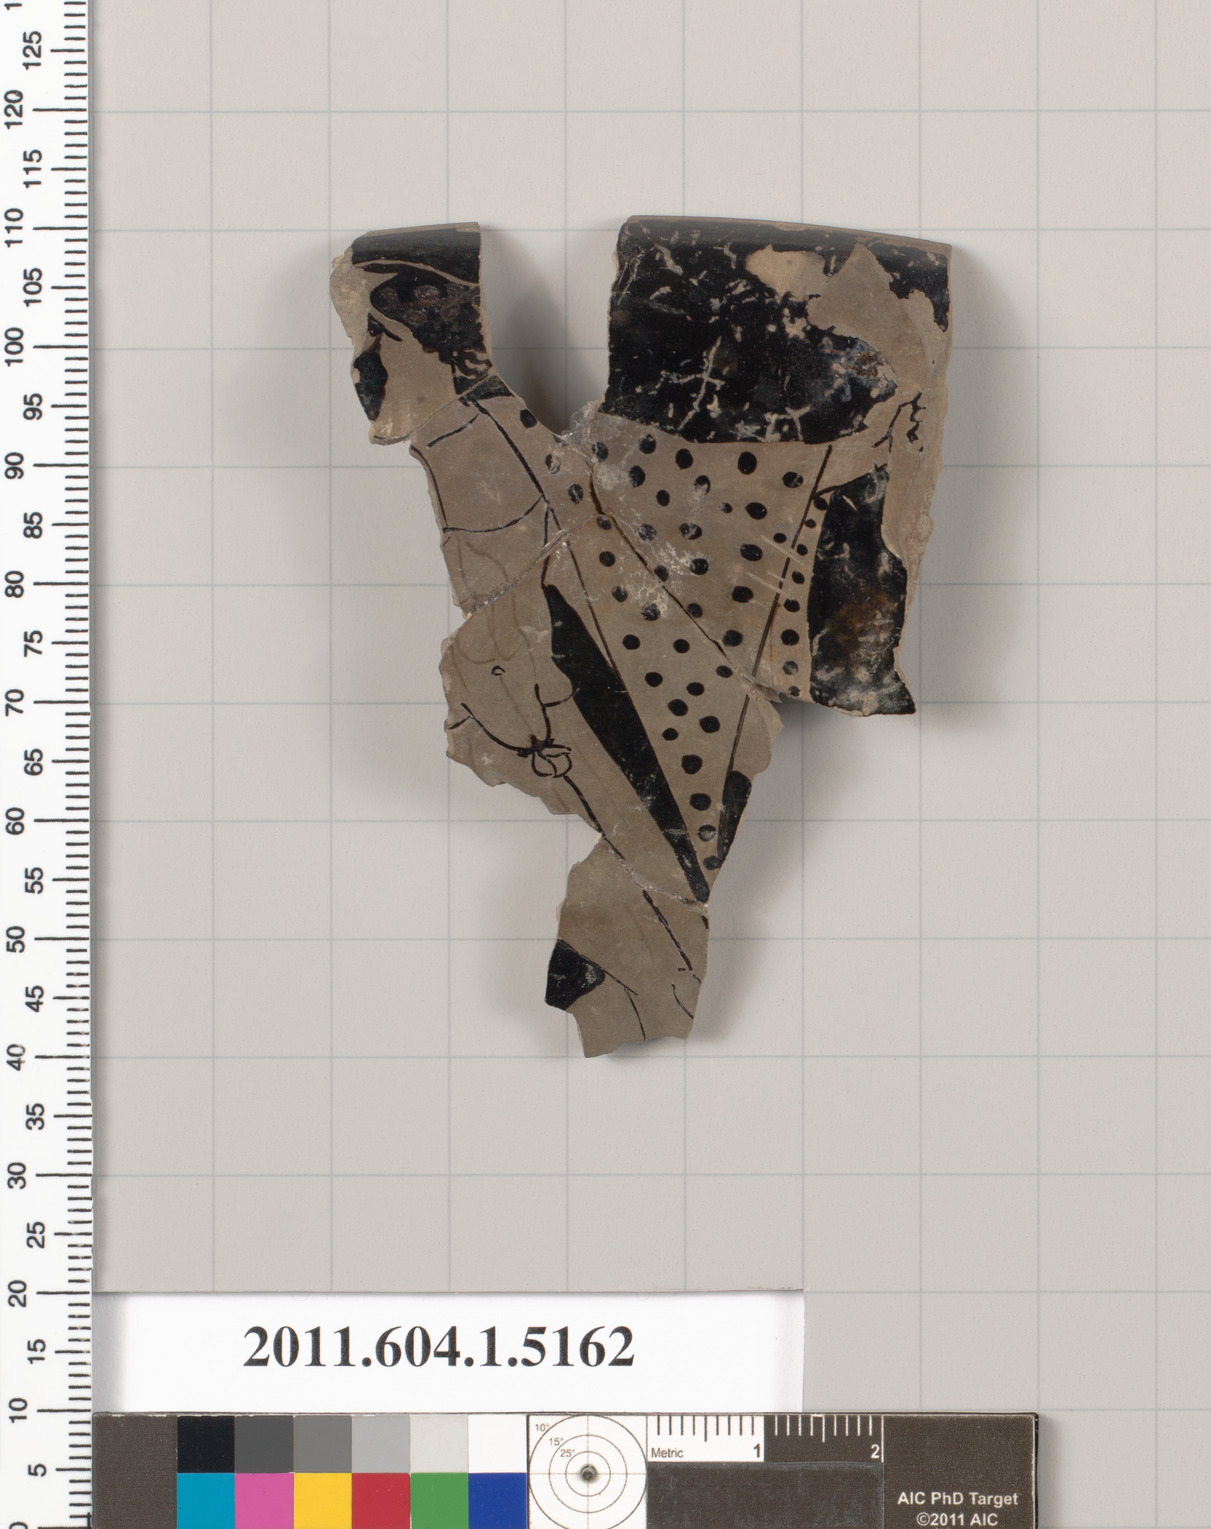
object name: kylix fragment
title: Terracotta rim fragment of a kylix (drinking cup)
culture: greek, attic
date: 500-480 BCE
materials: terracotta